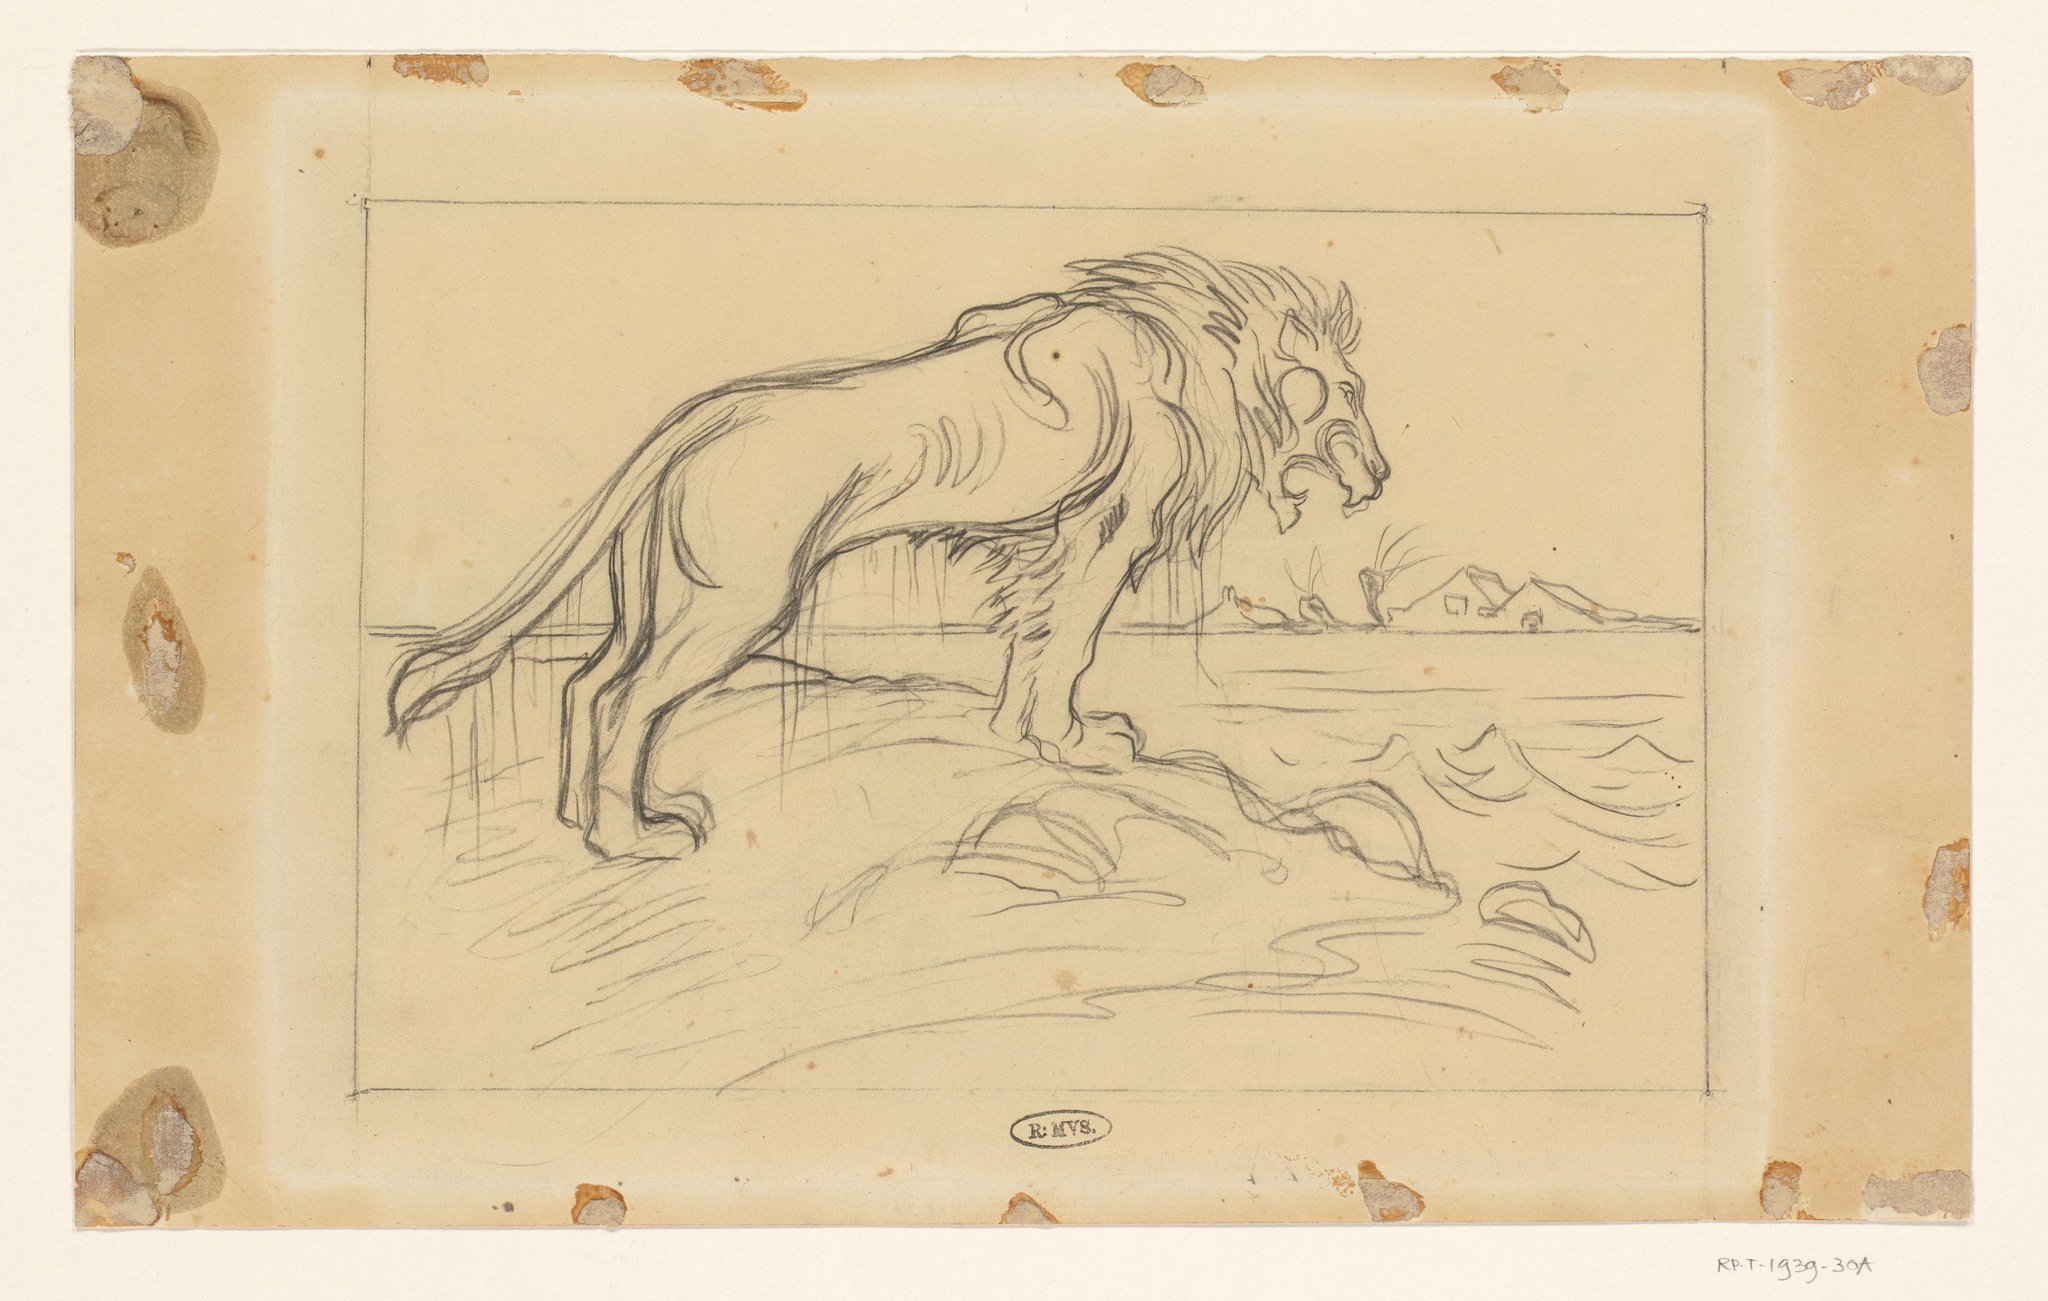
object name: drawing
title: Ontwerp voor een spotprent op de Stormvloed van 1906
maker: henricus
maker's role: draughtsman, print maker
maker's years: 1867-1921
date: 1906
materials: chalk, paper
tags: flood, beasts of prey, predatory animals: lion, political caricatures and satires, zeeland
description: De Zeeuwse leeuw staat op de rotsen en kijkt uit over een landschap dat onder water staat.